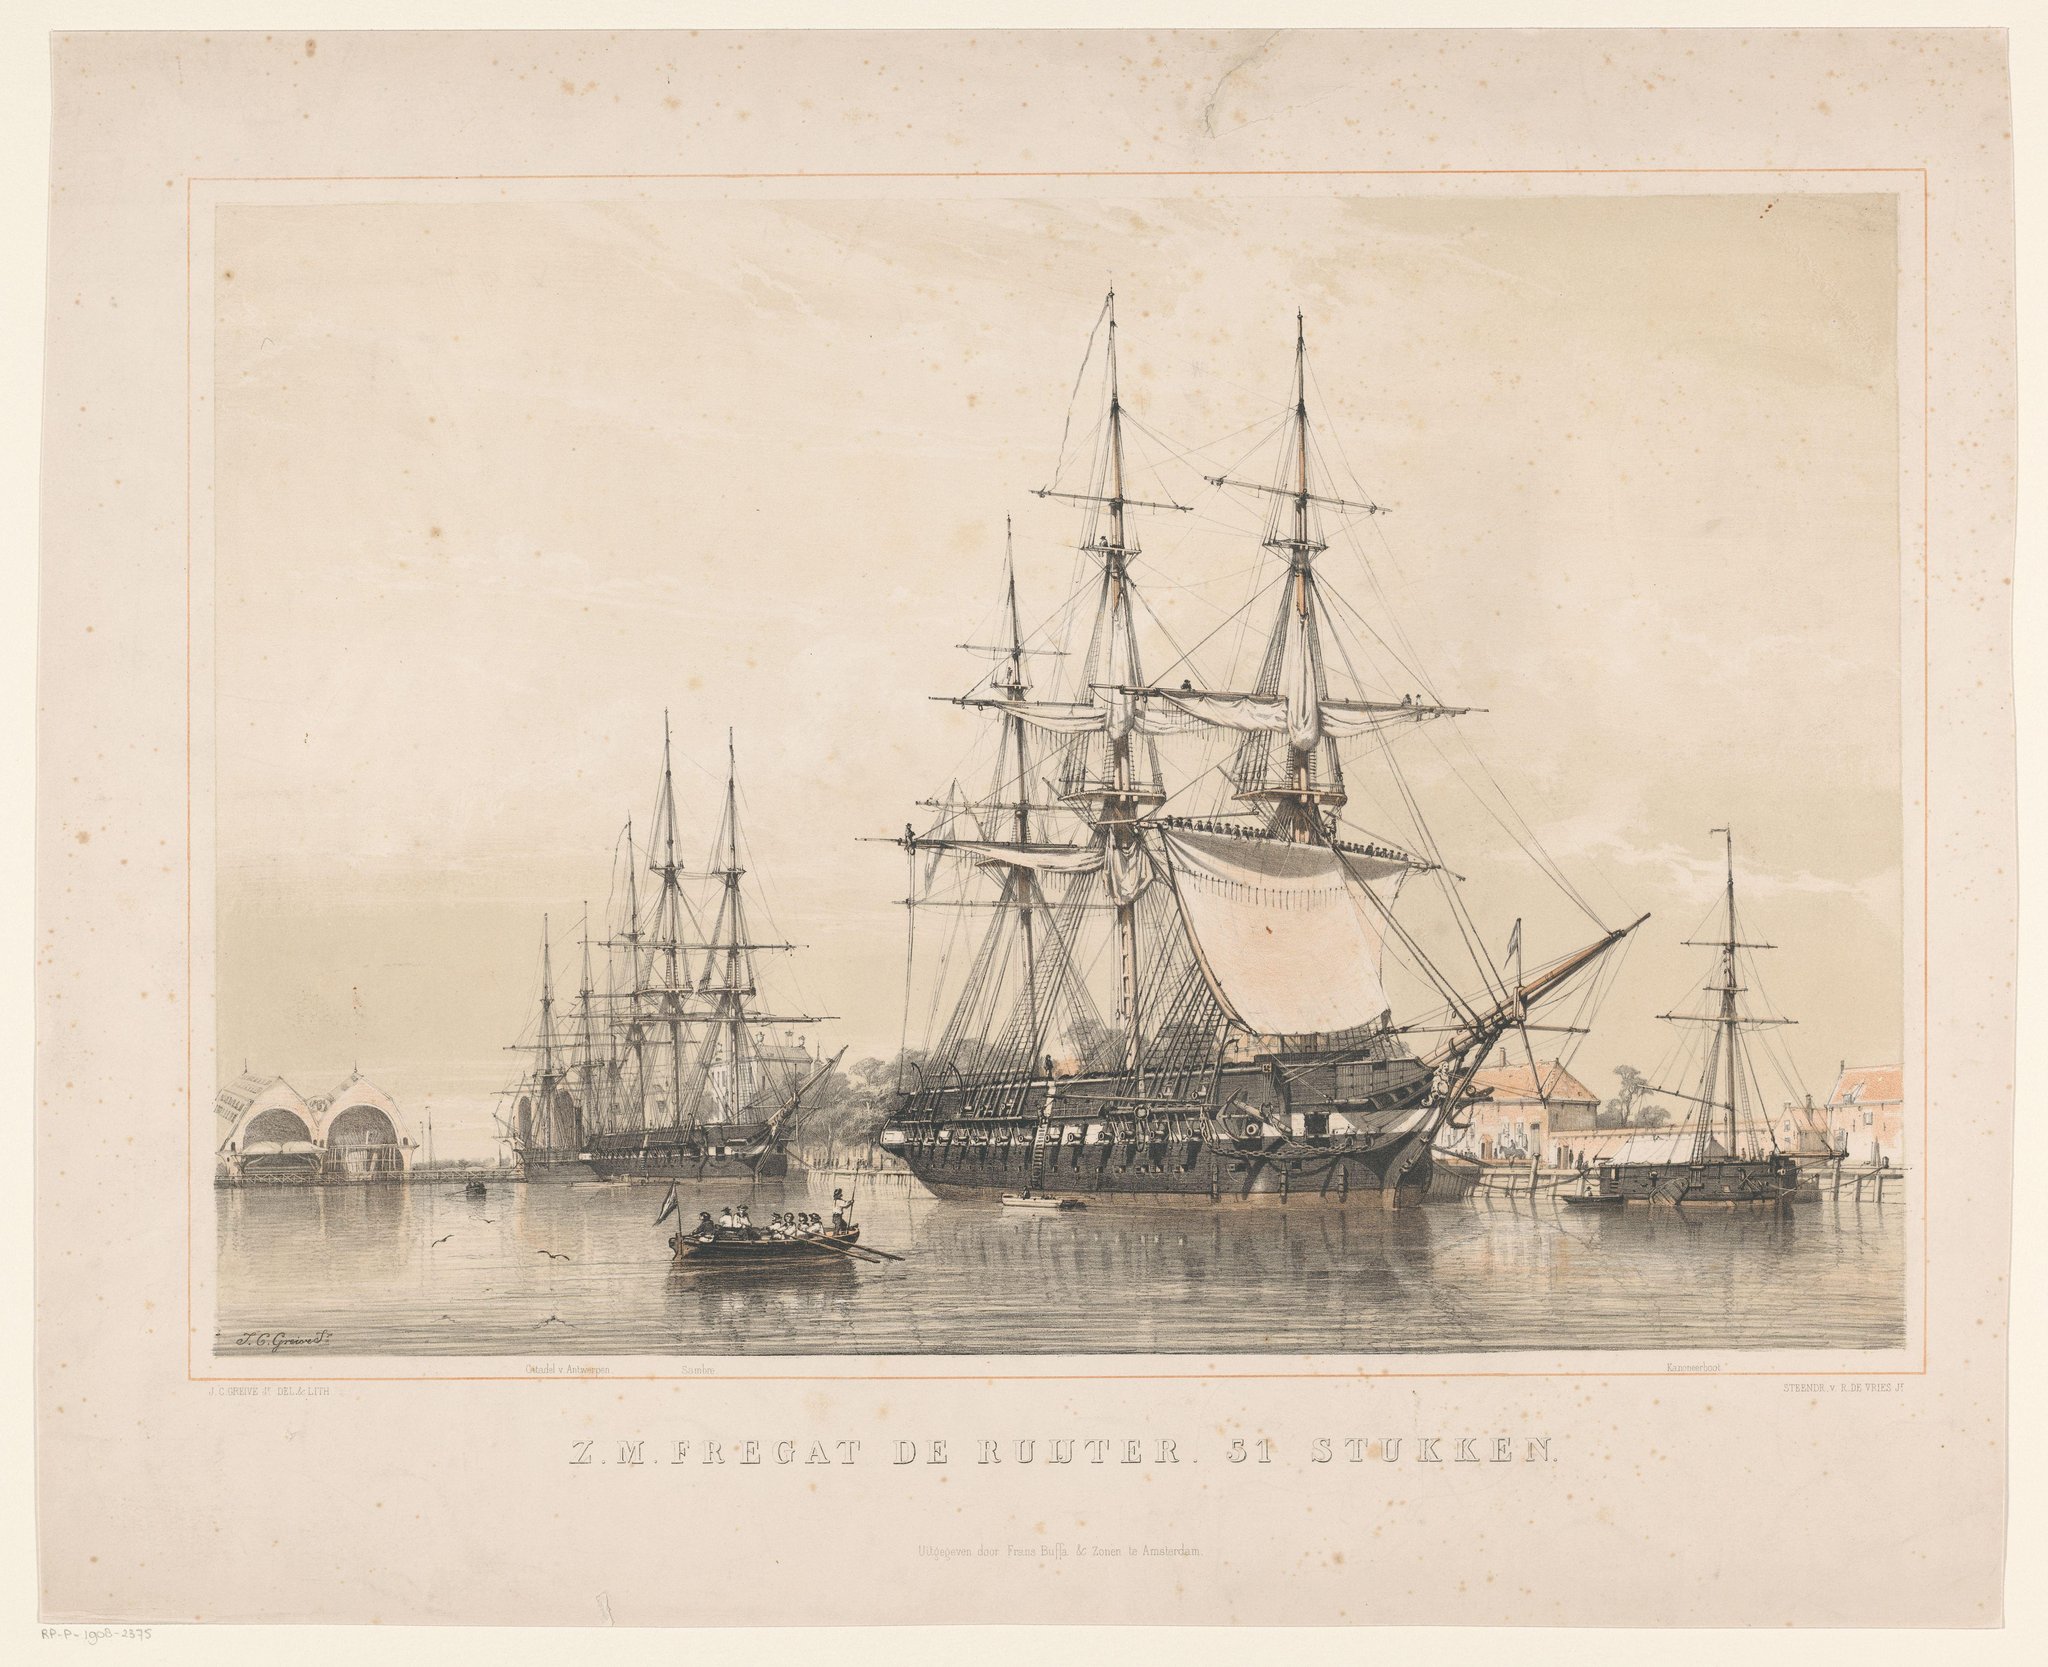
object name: print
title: Z.M. Fregat De Ruijter. 51 stukken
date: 1847-1874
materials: paper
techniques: tone lithography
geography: amsterdam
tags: ships (in general), antwerp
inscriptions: collector's mark: Lugt 2228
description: Fregat de Ruijter liggend in de haven van Antwerpen, met links twee schepen, rechts een kanonneerboot en op de voorgrond een roeiboot.